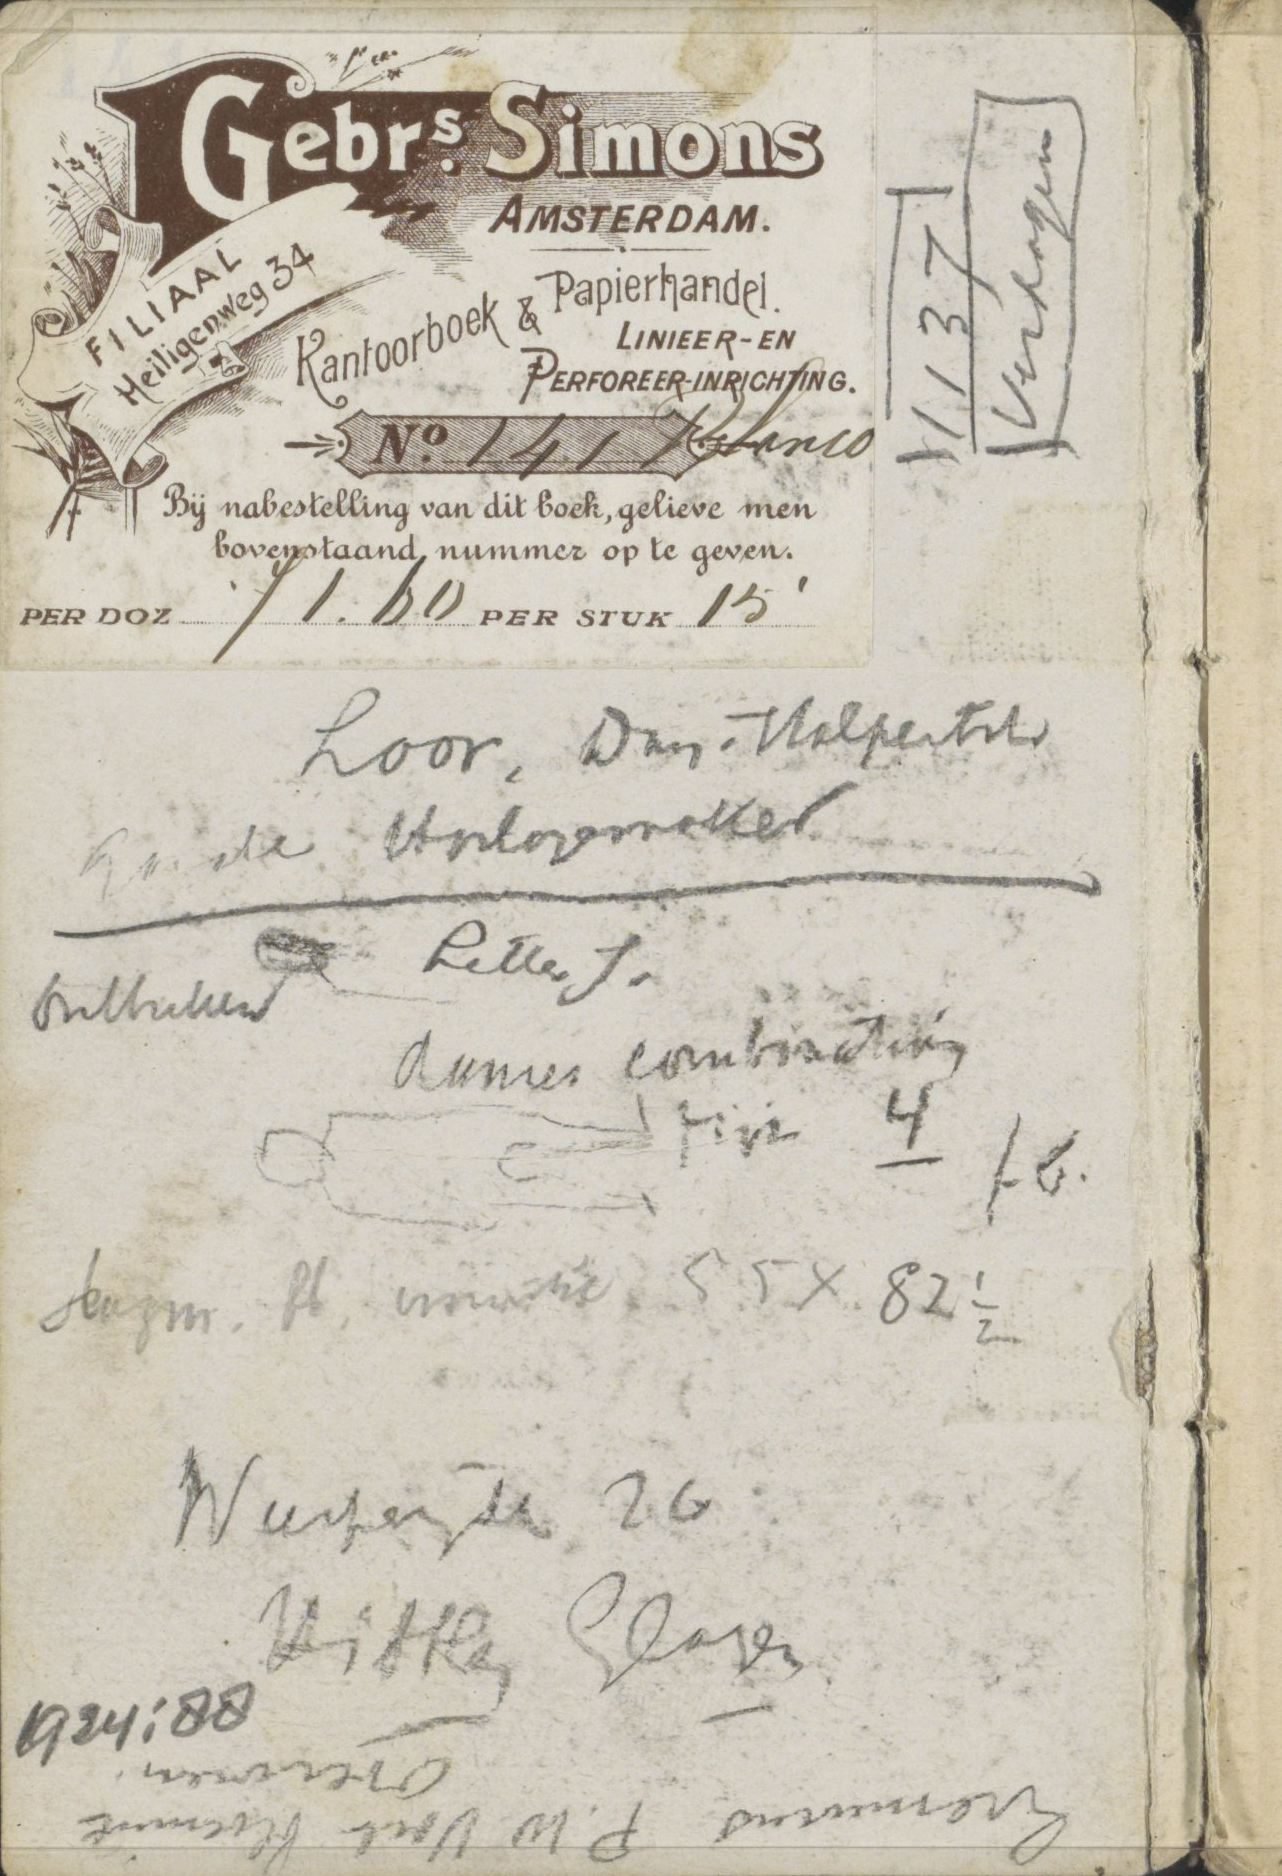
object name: sketchbook leaf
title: Annotaties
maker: george hendrik breitner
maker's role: draughtsman, painter, print maker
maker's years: 1857-1923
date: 1902-1914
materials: chalk, paper, pencil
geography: amsterdam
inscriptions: retailer's mark: ‘Gebrs. Simons/ Amsterdam./ Filiaal/ Heiligenweg 34/ Kantoorboek & Papierhandel./ Linieer- en Perforeer-inrichting./ No. 141 Blanco/ Bij nabestelling van dit boek, gelieve men/ bovenstaand nummer op te geven. / per doz f 1.60 per stuk 15’, annotation: ‘P.W. Voet bloemist/ Overveen’, address: ‘Weesperzijde 20’, annotation: ‘1137/ Verhagen’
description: Aantekeningen. Pagina 1, voorste schutblad, uit een schetsboek met 46 bladen vervaardigd te Noord-Holland en Utrecht.